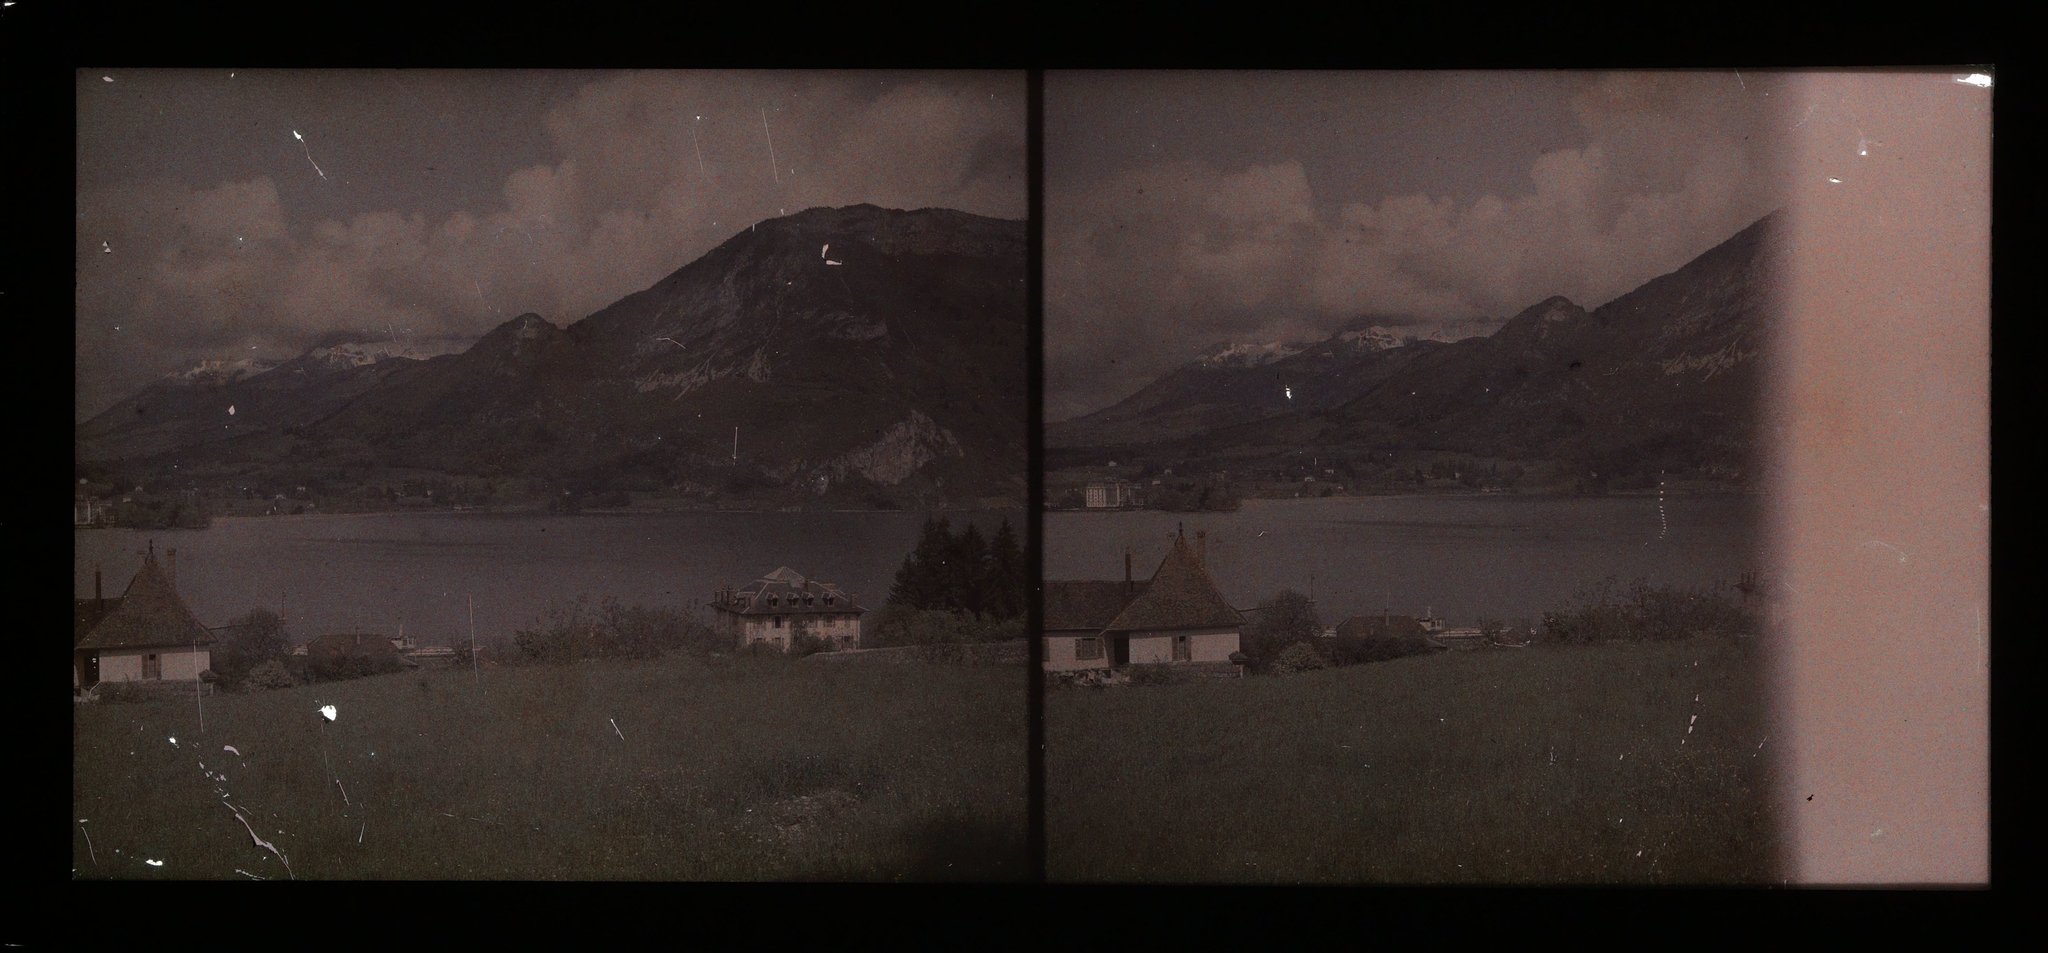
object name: stereograph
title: Meer aan de voet van een berg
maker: Anonymous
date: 1910-1940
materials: glass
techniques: autochrome process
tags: lake